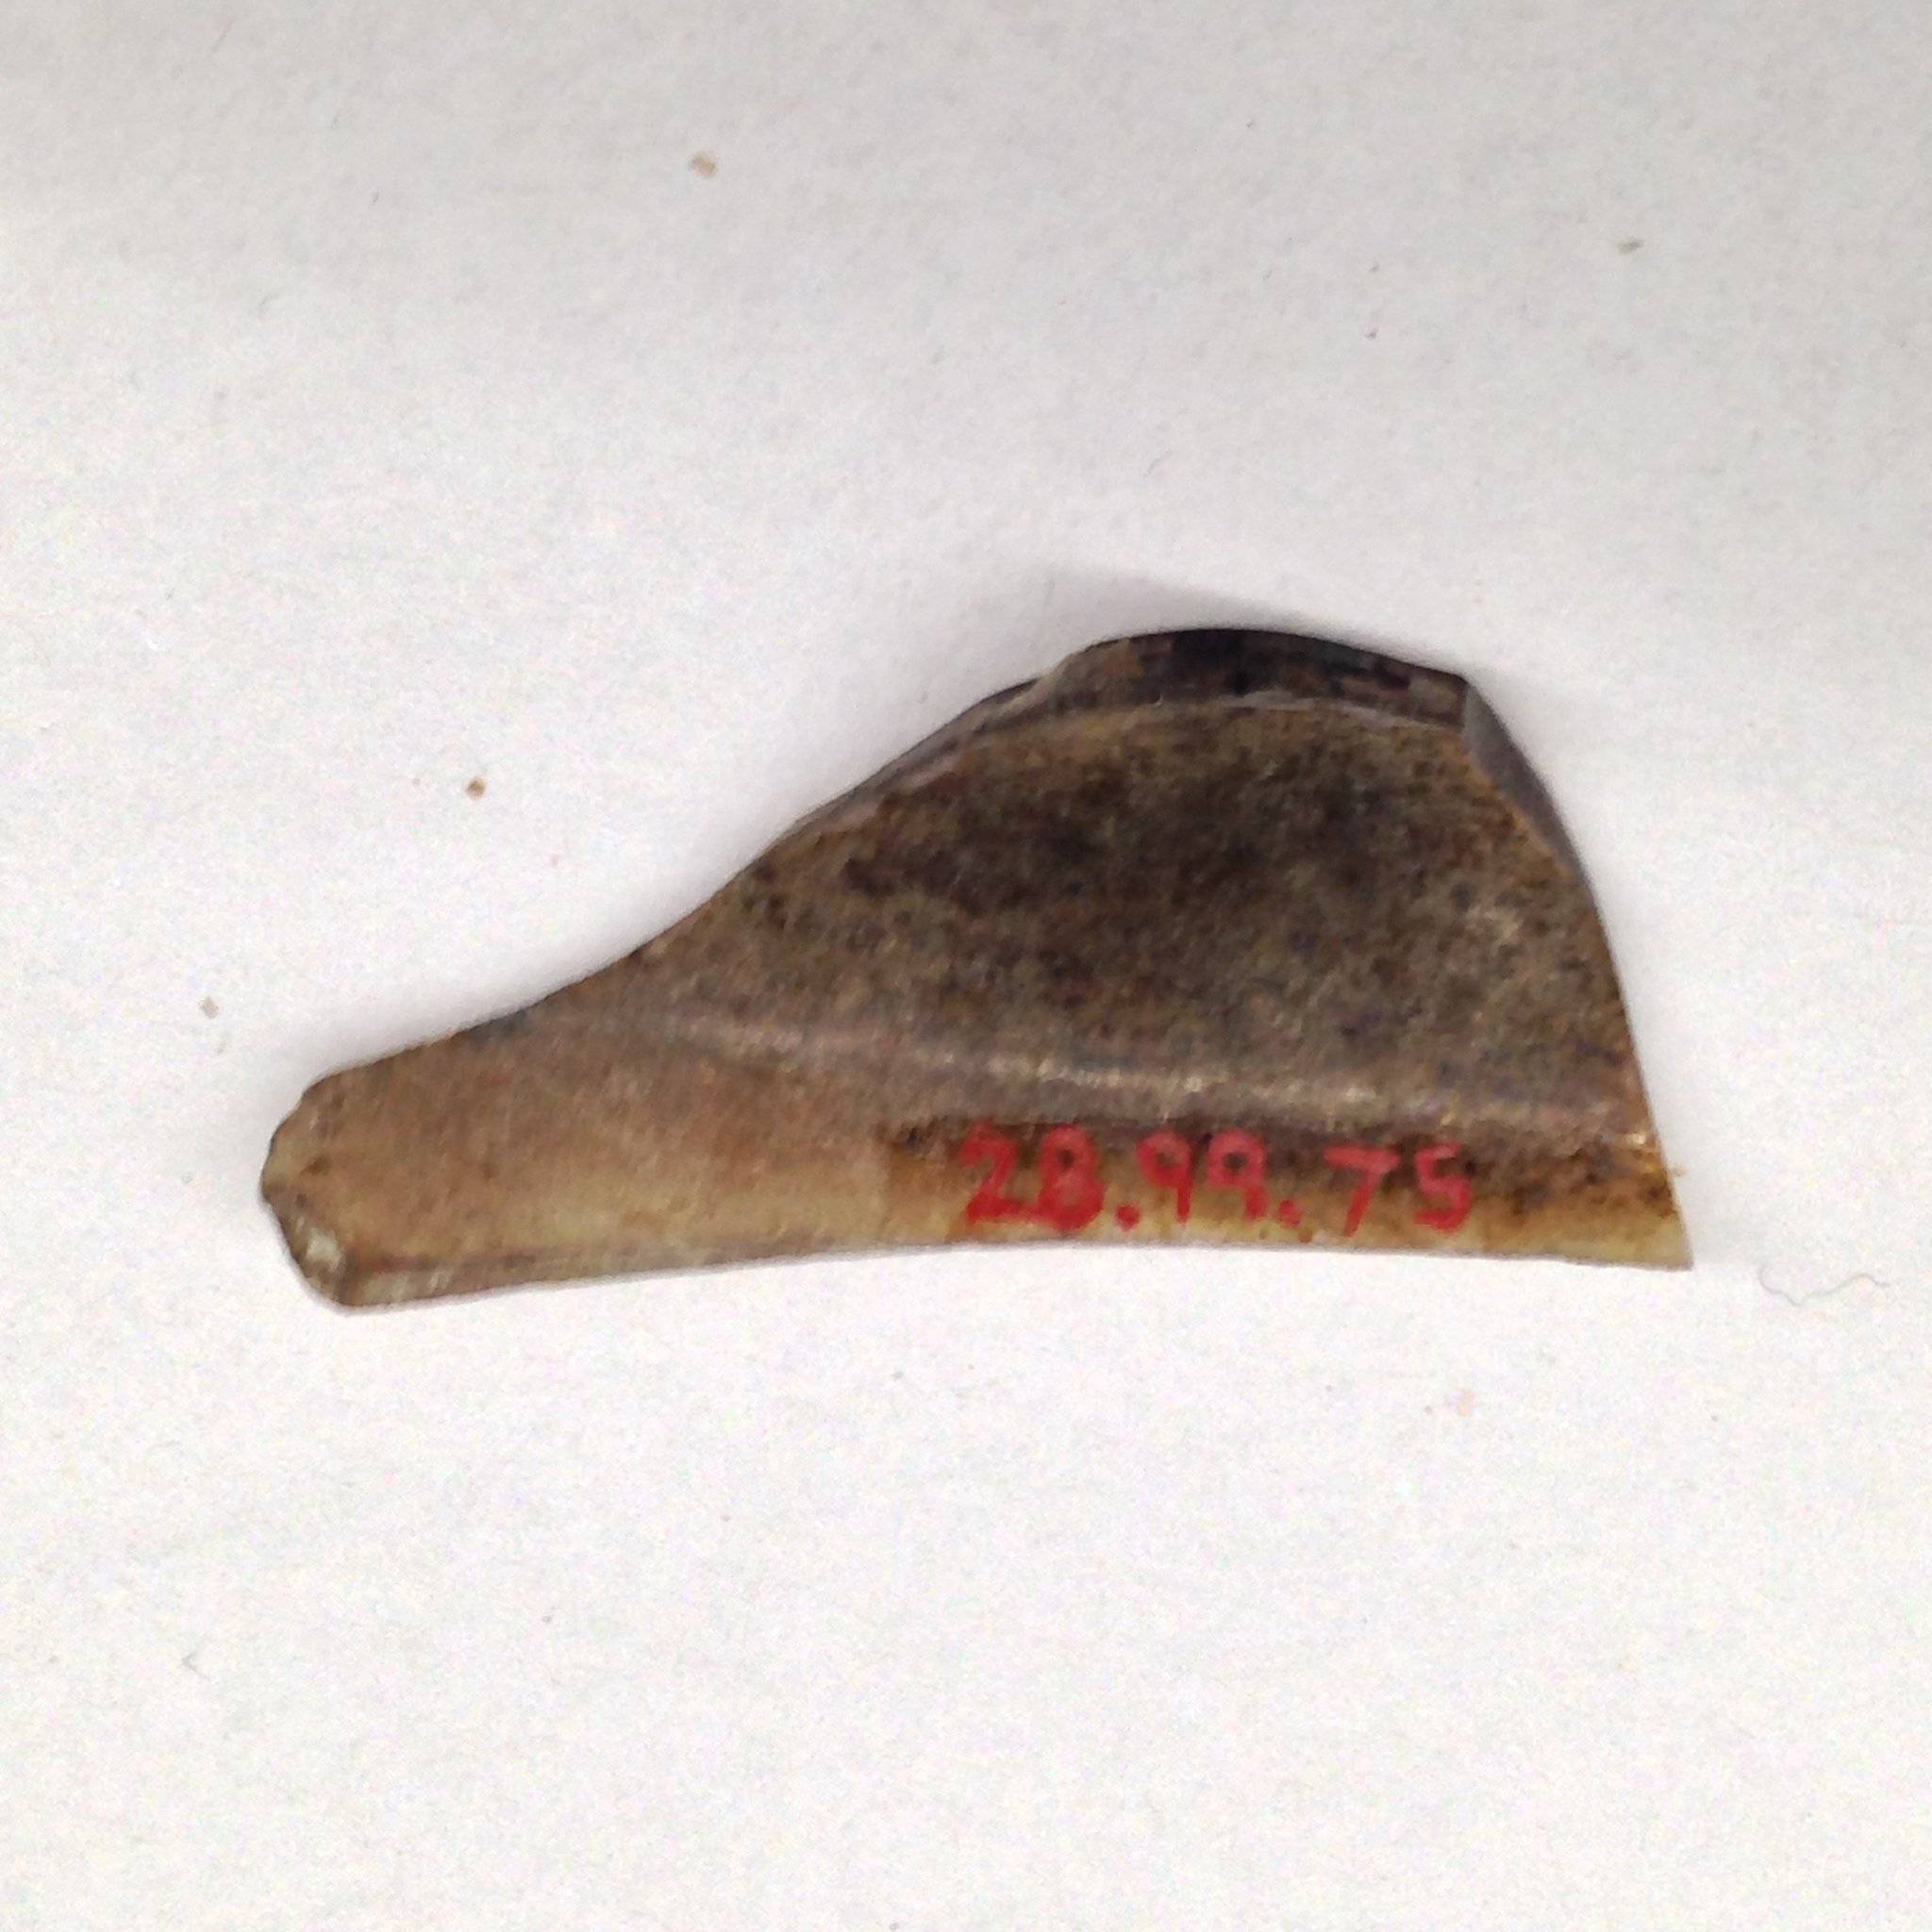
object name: fragment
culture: european or middle eastern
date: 1150-1250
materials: ceramic, glass